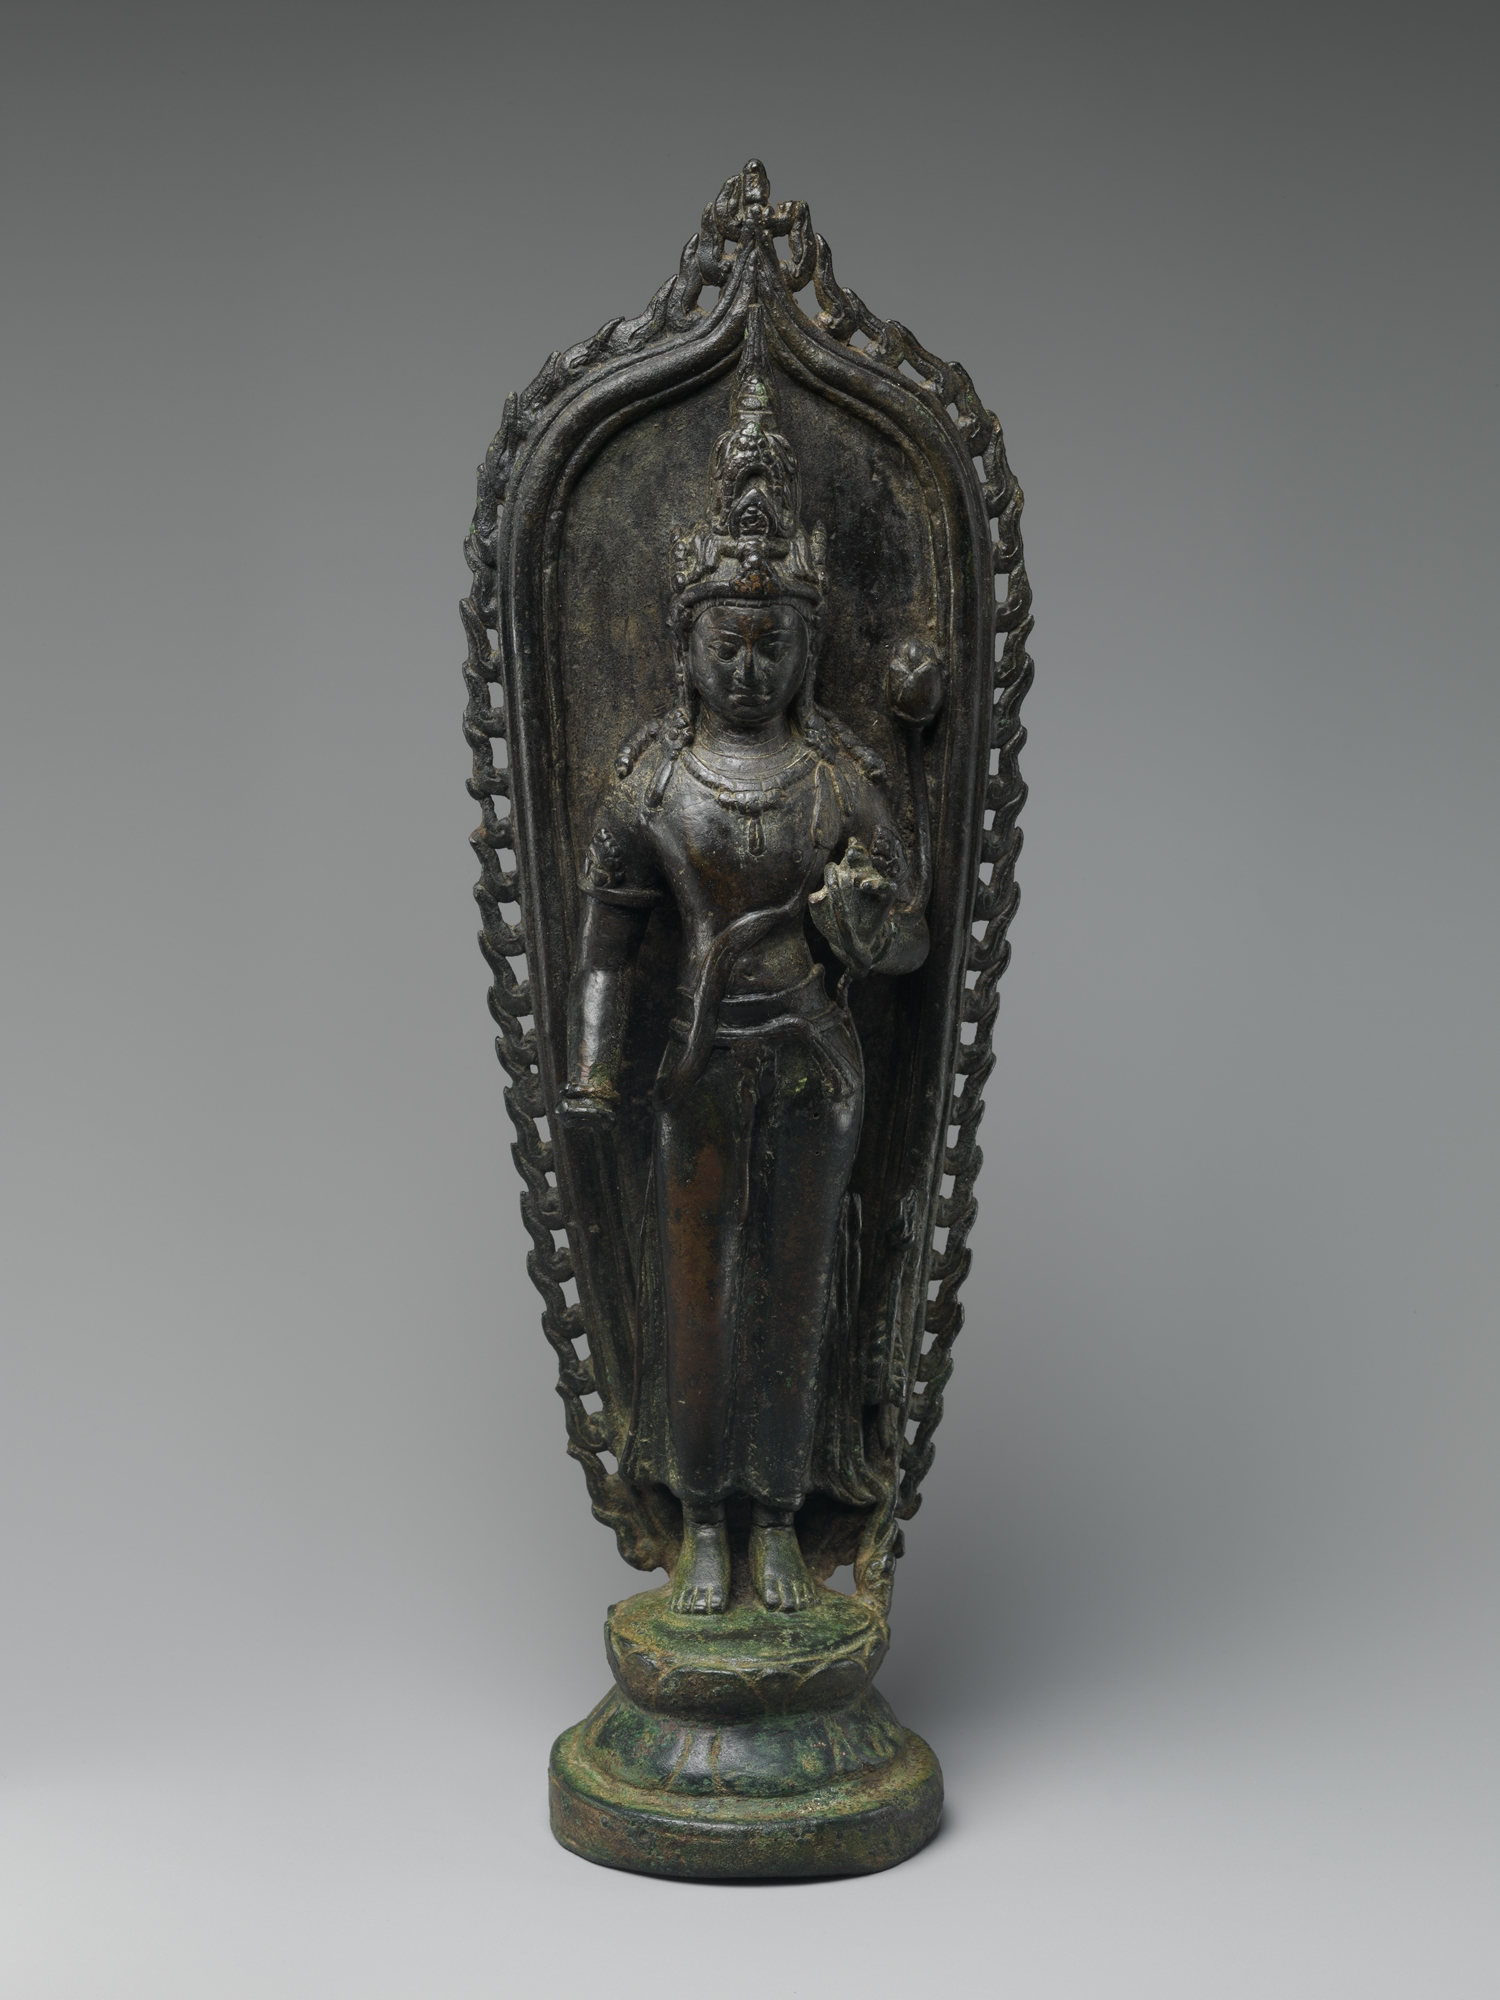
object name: figure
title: Standing Padmapani Lokeshvara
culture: indonesian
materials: bronze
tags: buddhism,bodhisattvas